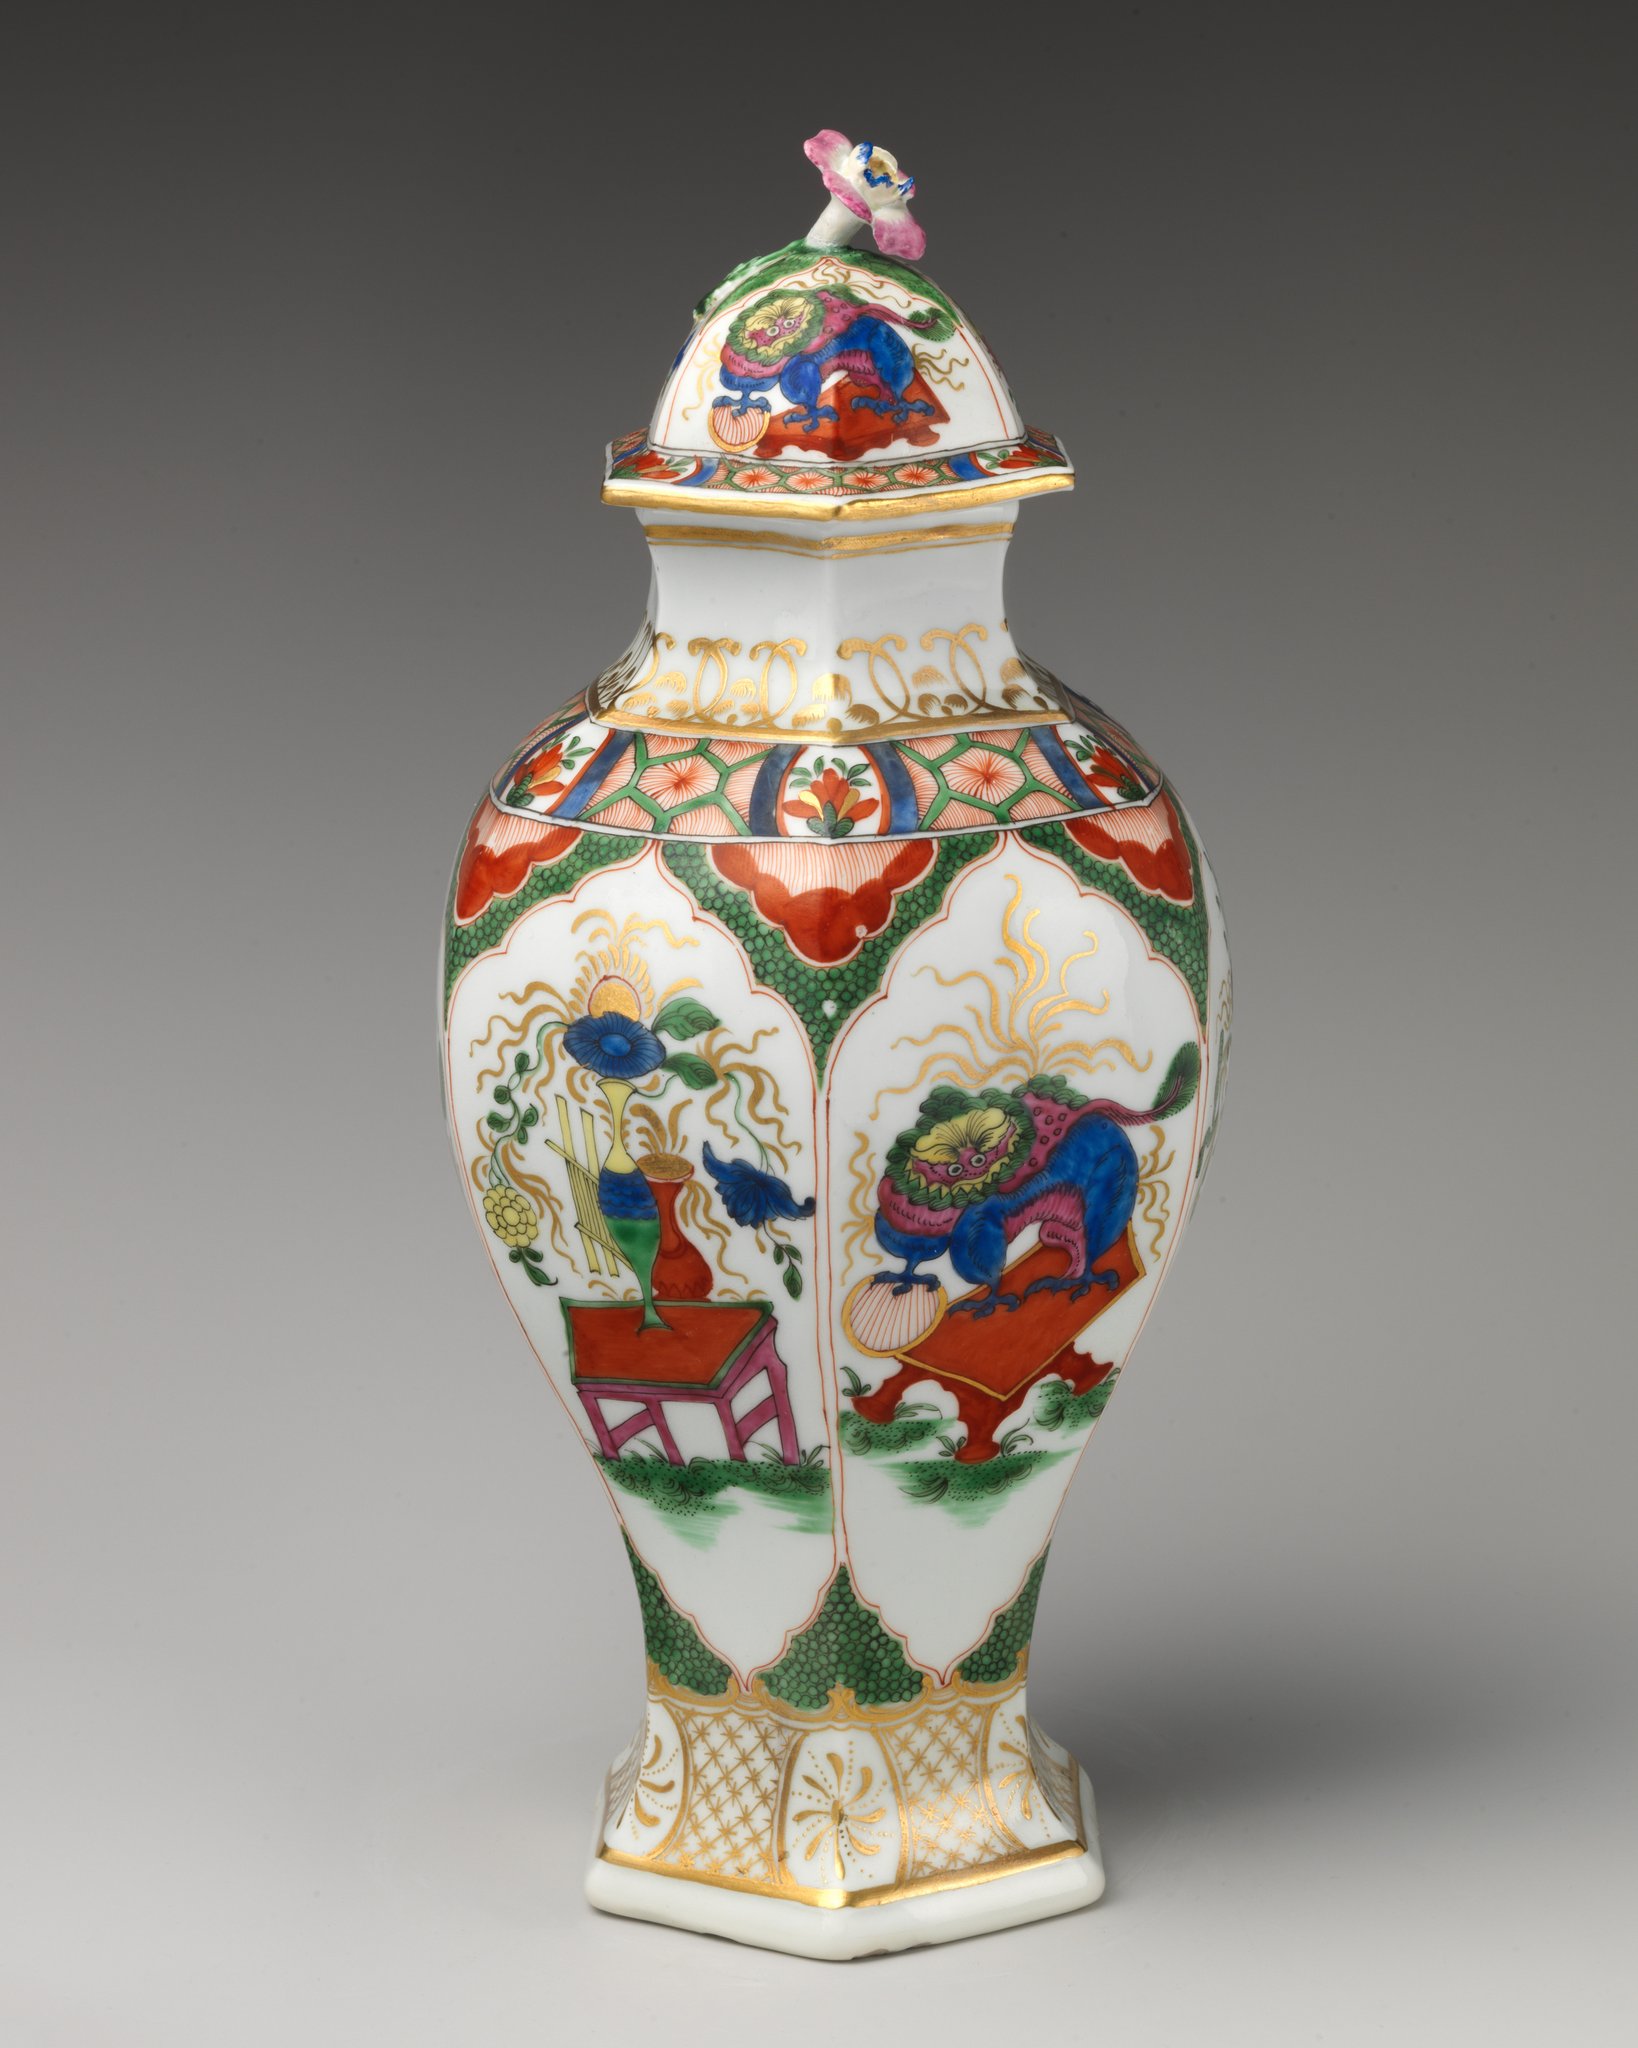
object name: vase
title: Covered vase (one of a pair)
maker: worcester factory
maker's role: factory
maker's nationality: british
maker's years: 1751-2008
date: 1765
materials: soft paste porcelain